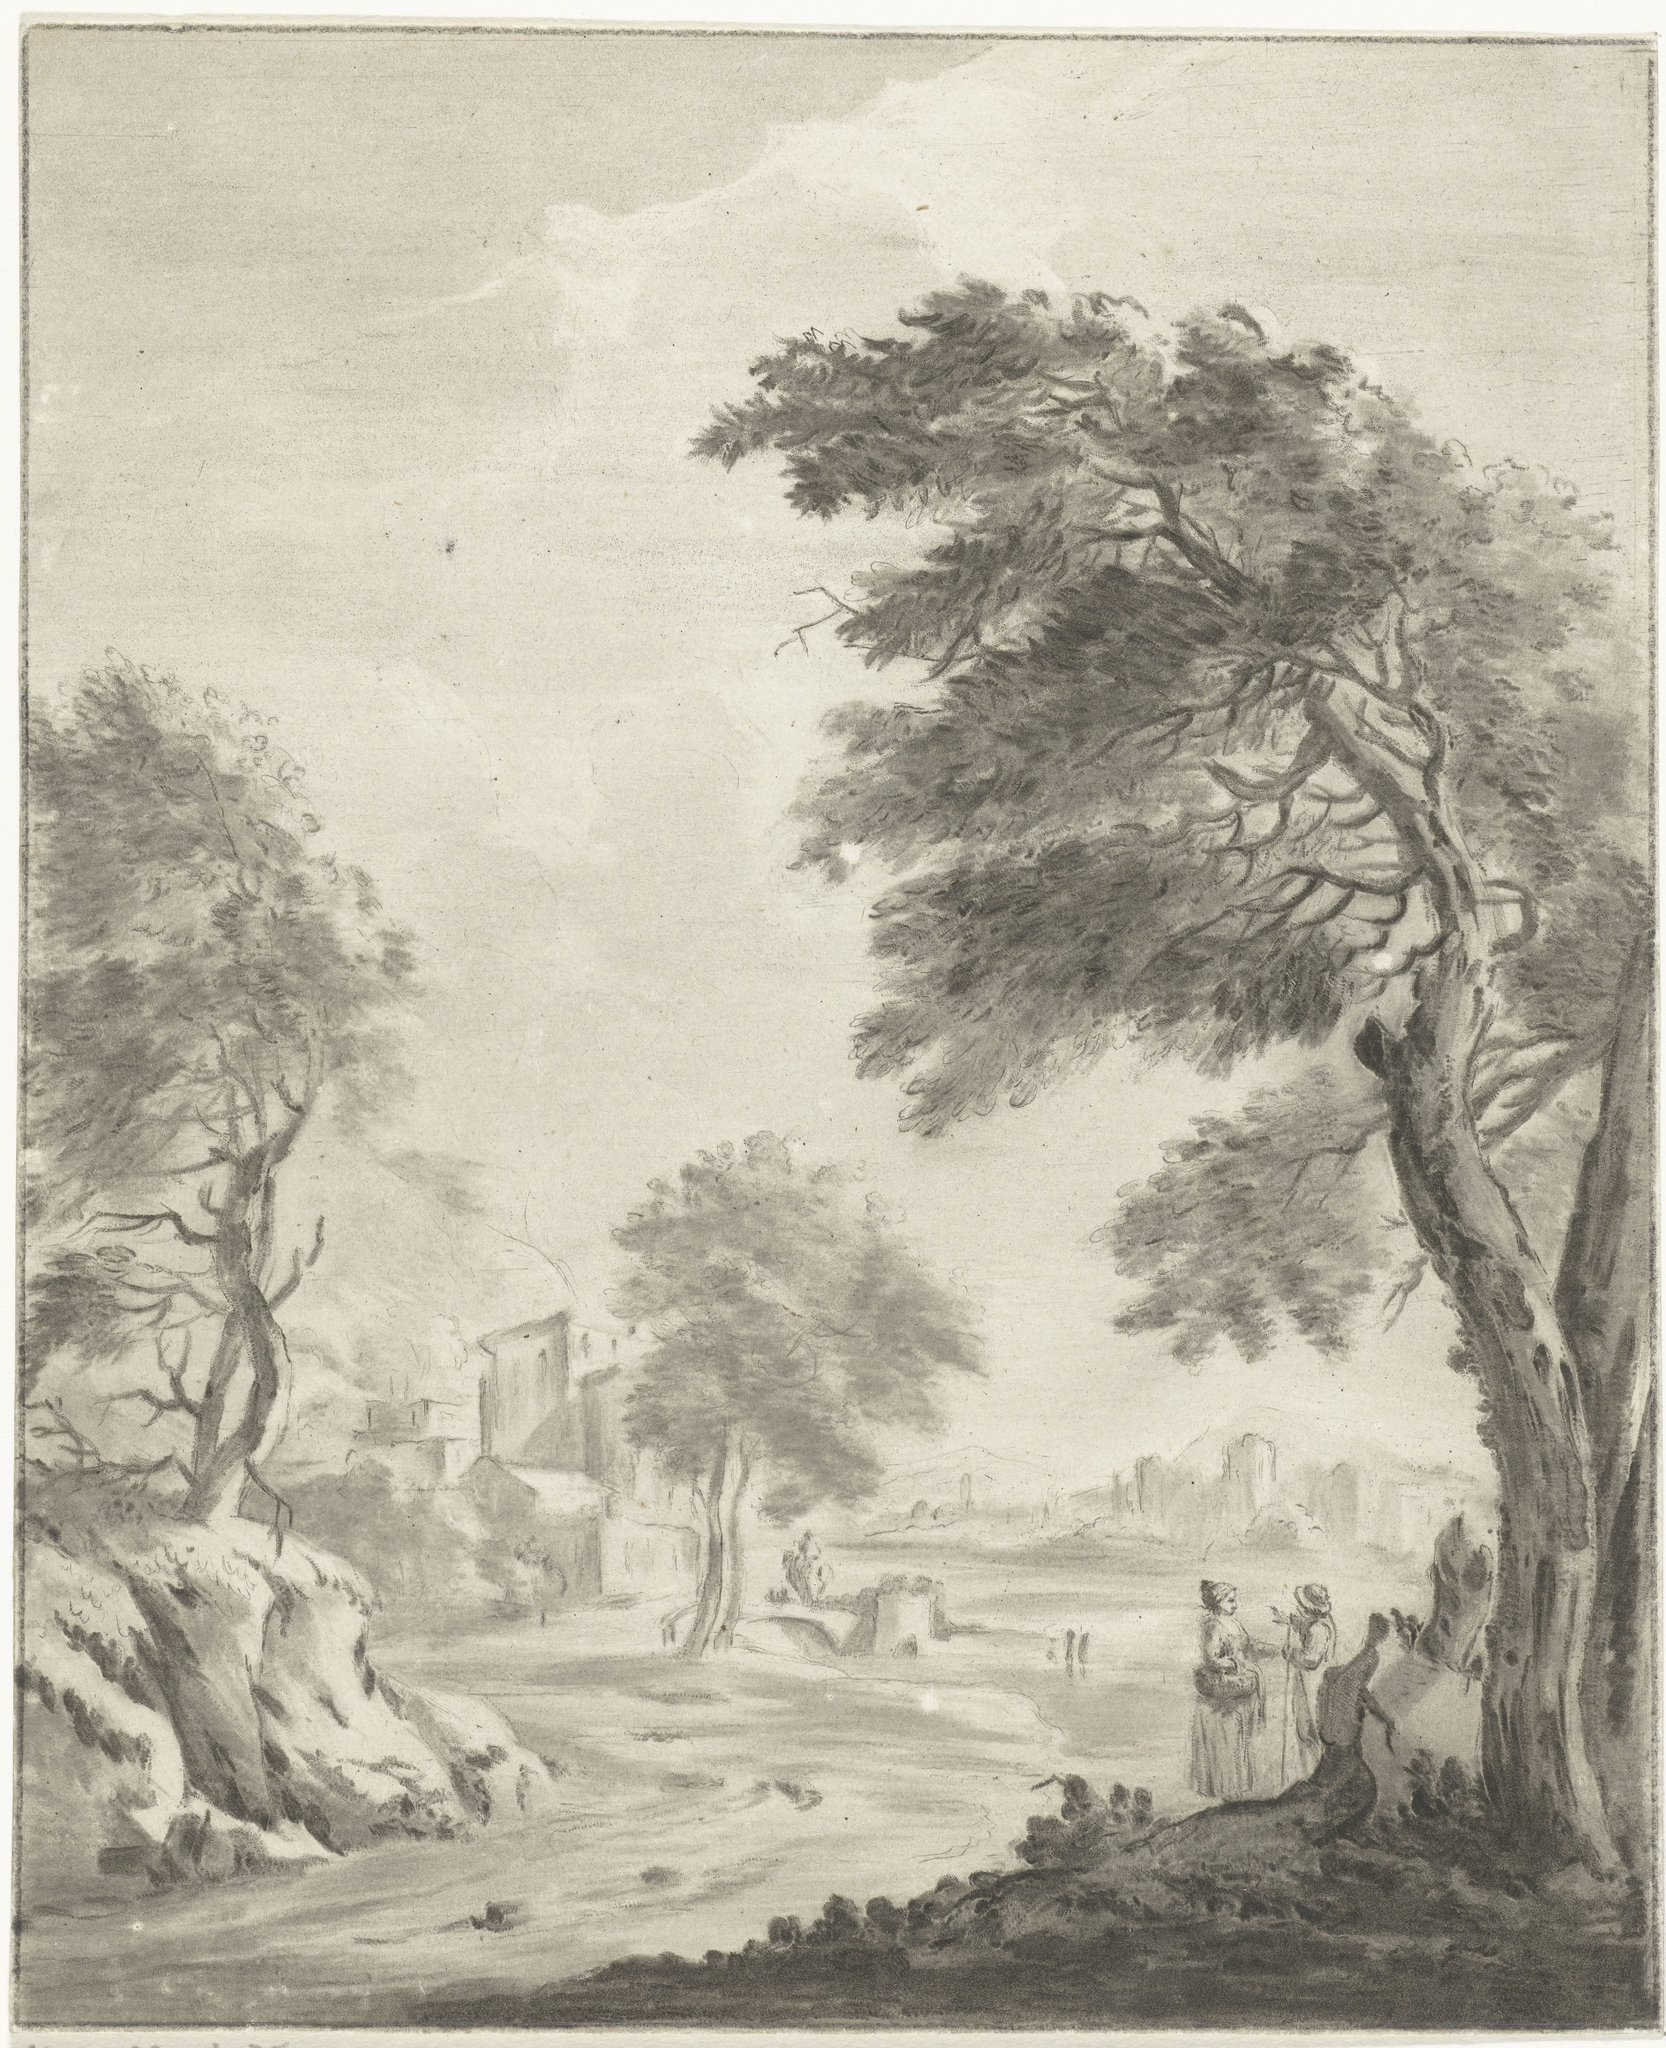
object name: print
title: Landschap met weg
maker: jurriaan cootwijck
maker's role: print maker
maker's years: 1714-1798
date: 1724-1798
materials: paper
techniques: print drawing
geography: amsterdam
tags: river, outskirts of city, public road (+ city(-scape) with figures, staffage)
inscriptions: collector's mark: Lugt 2228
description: Landschap met op de voorgrond voetgangers aan de kant van een weg. In de achtergrond de contouren van een stad. De weg volgt een rivier richting de stad.